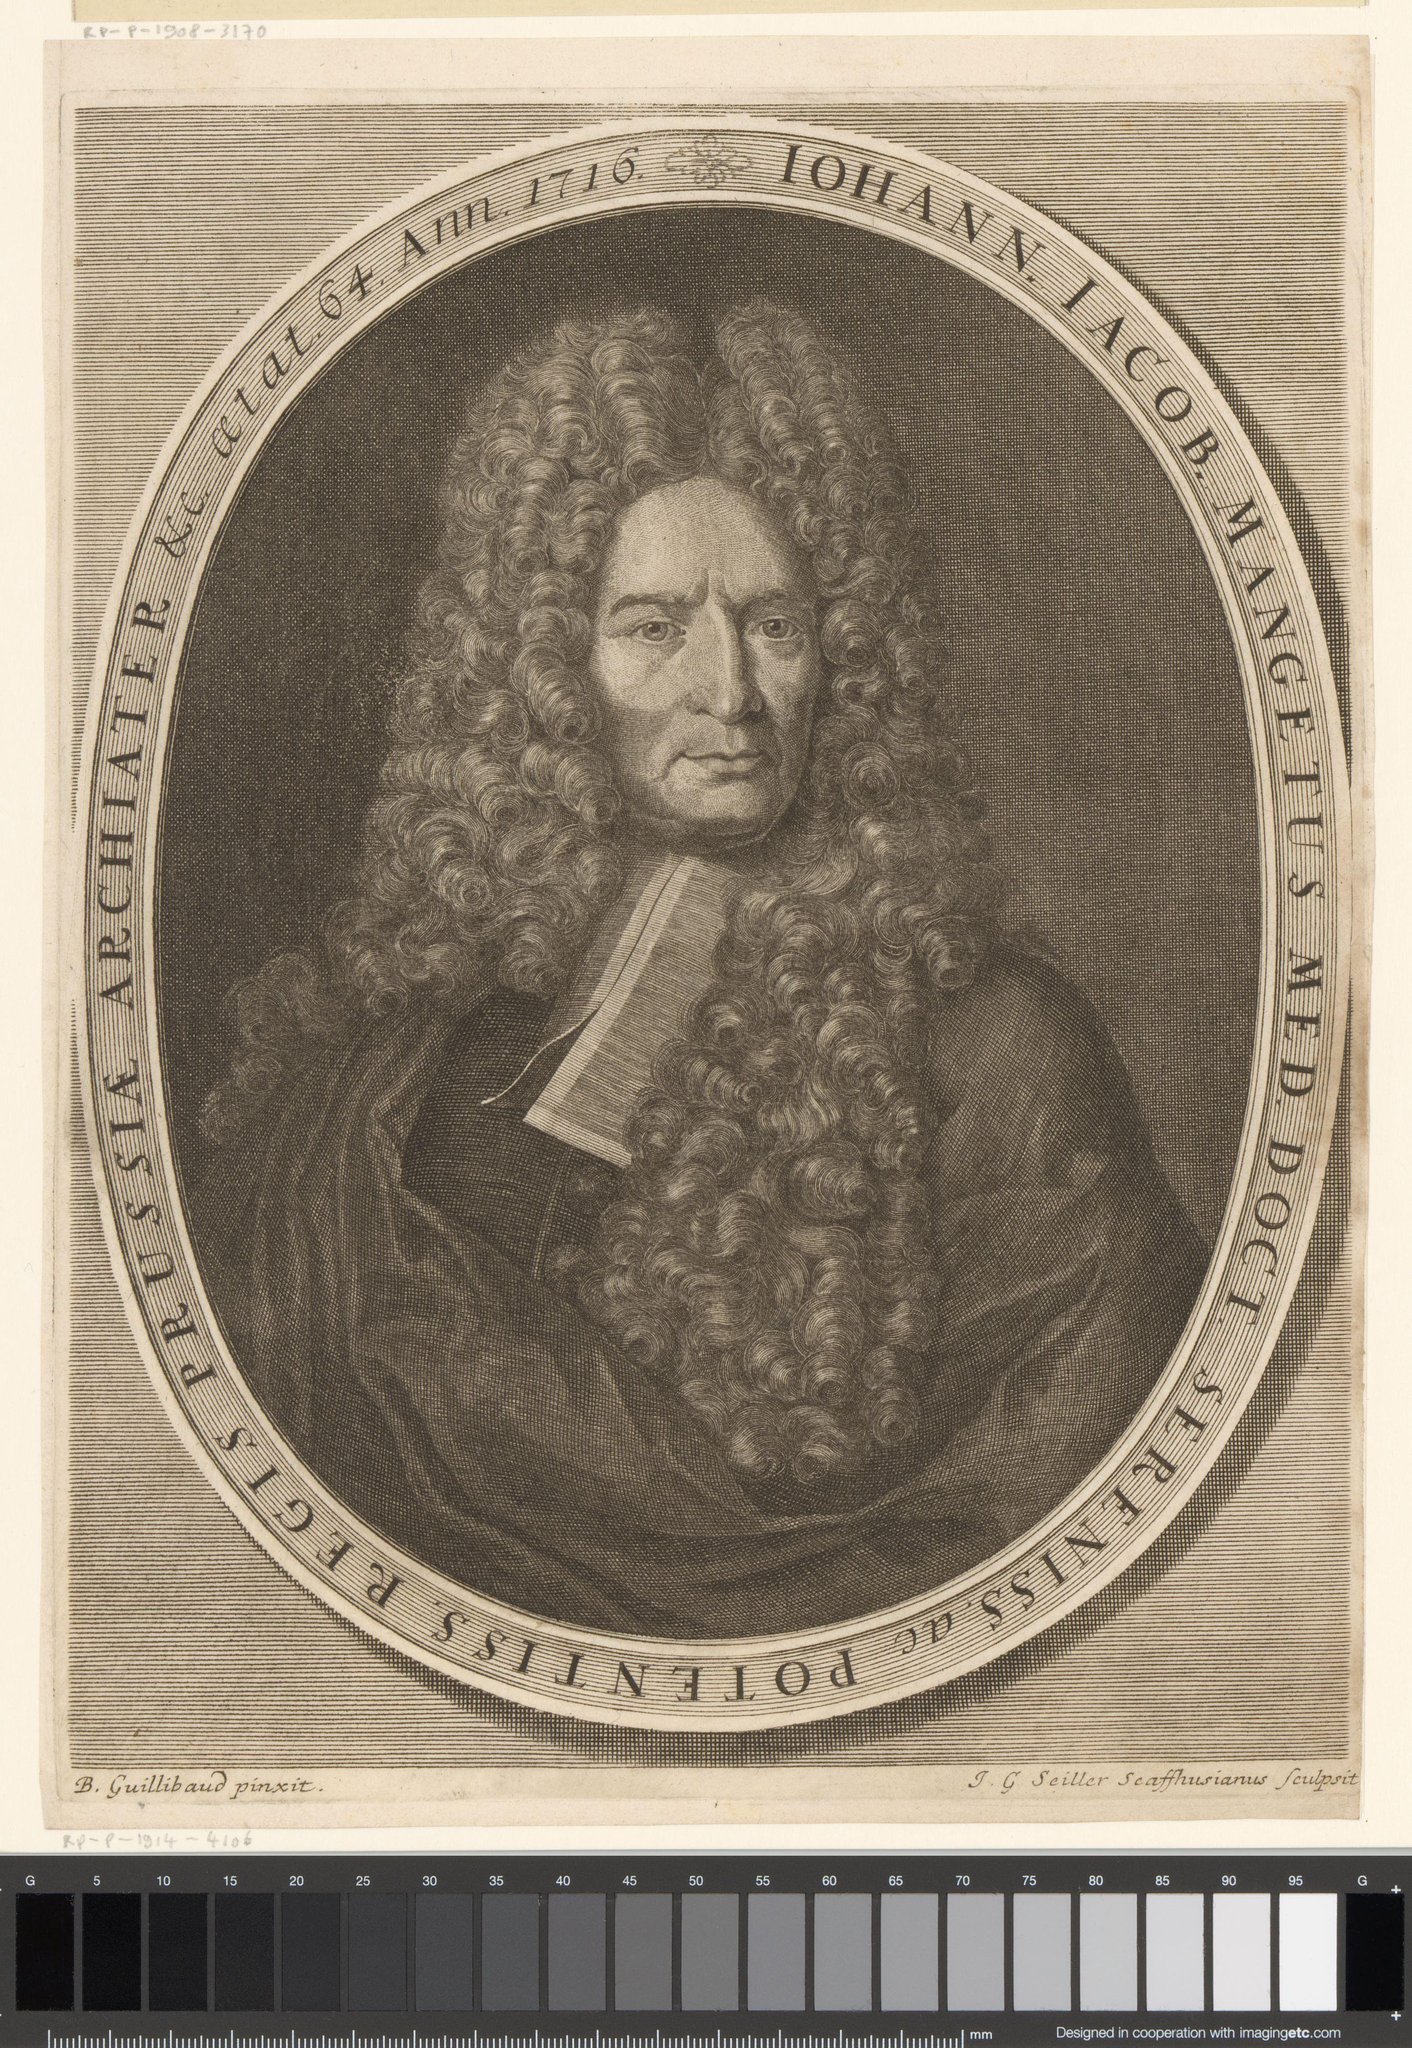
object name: print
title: Portret van Jean-Jacques Manget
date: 1673-1740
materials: paper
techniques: engraving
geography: schaffhausen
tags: historical persons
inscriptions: collector's mark: Lugt 2228